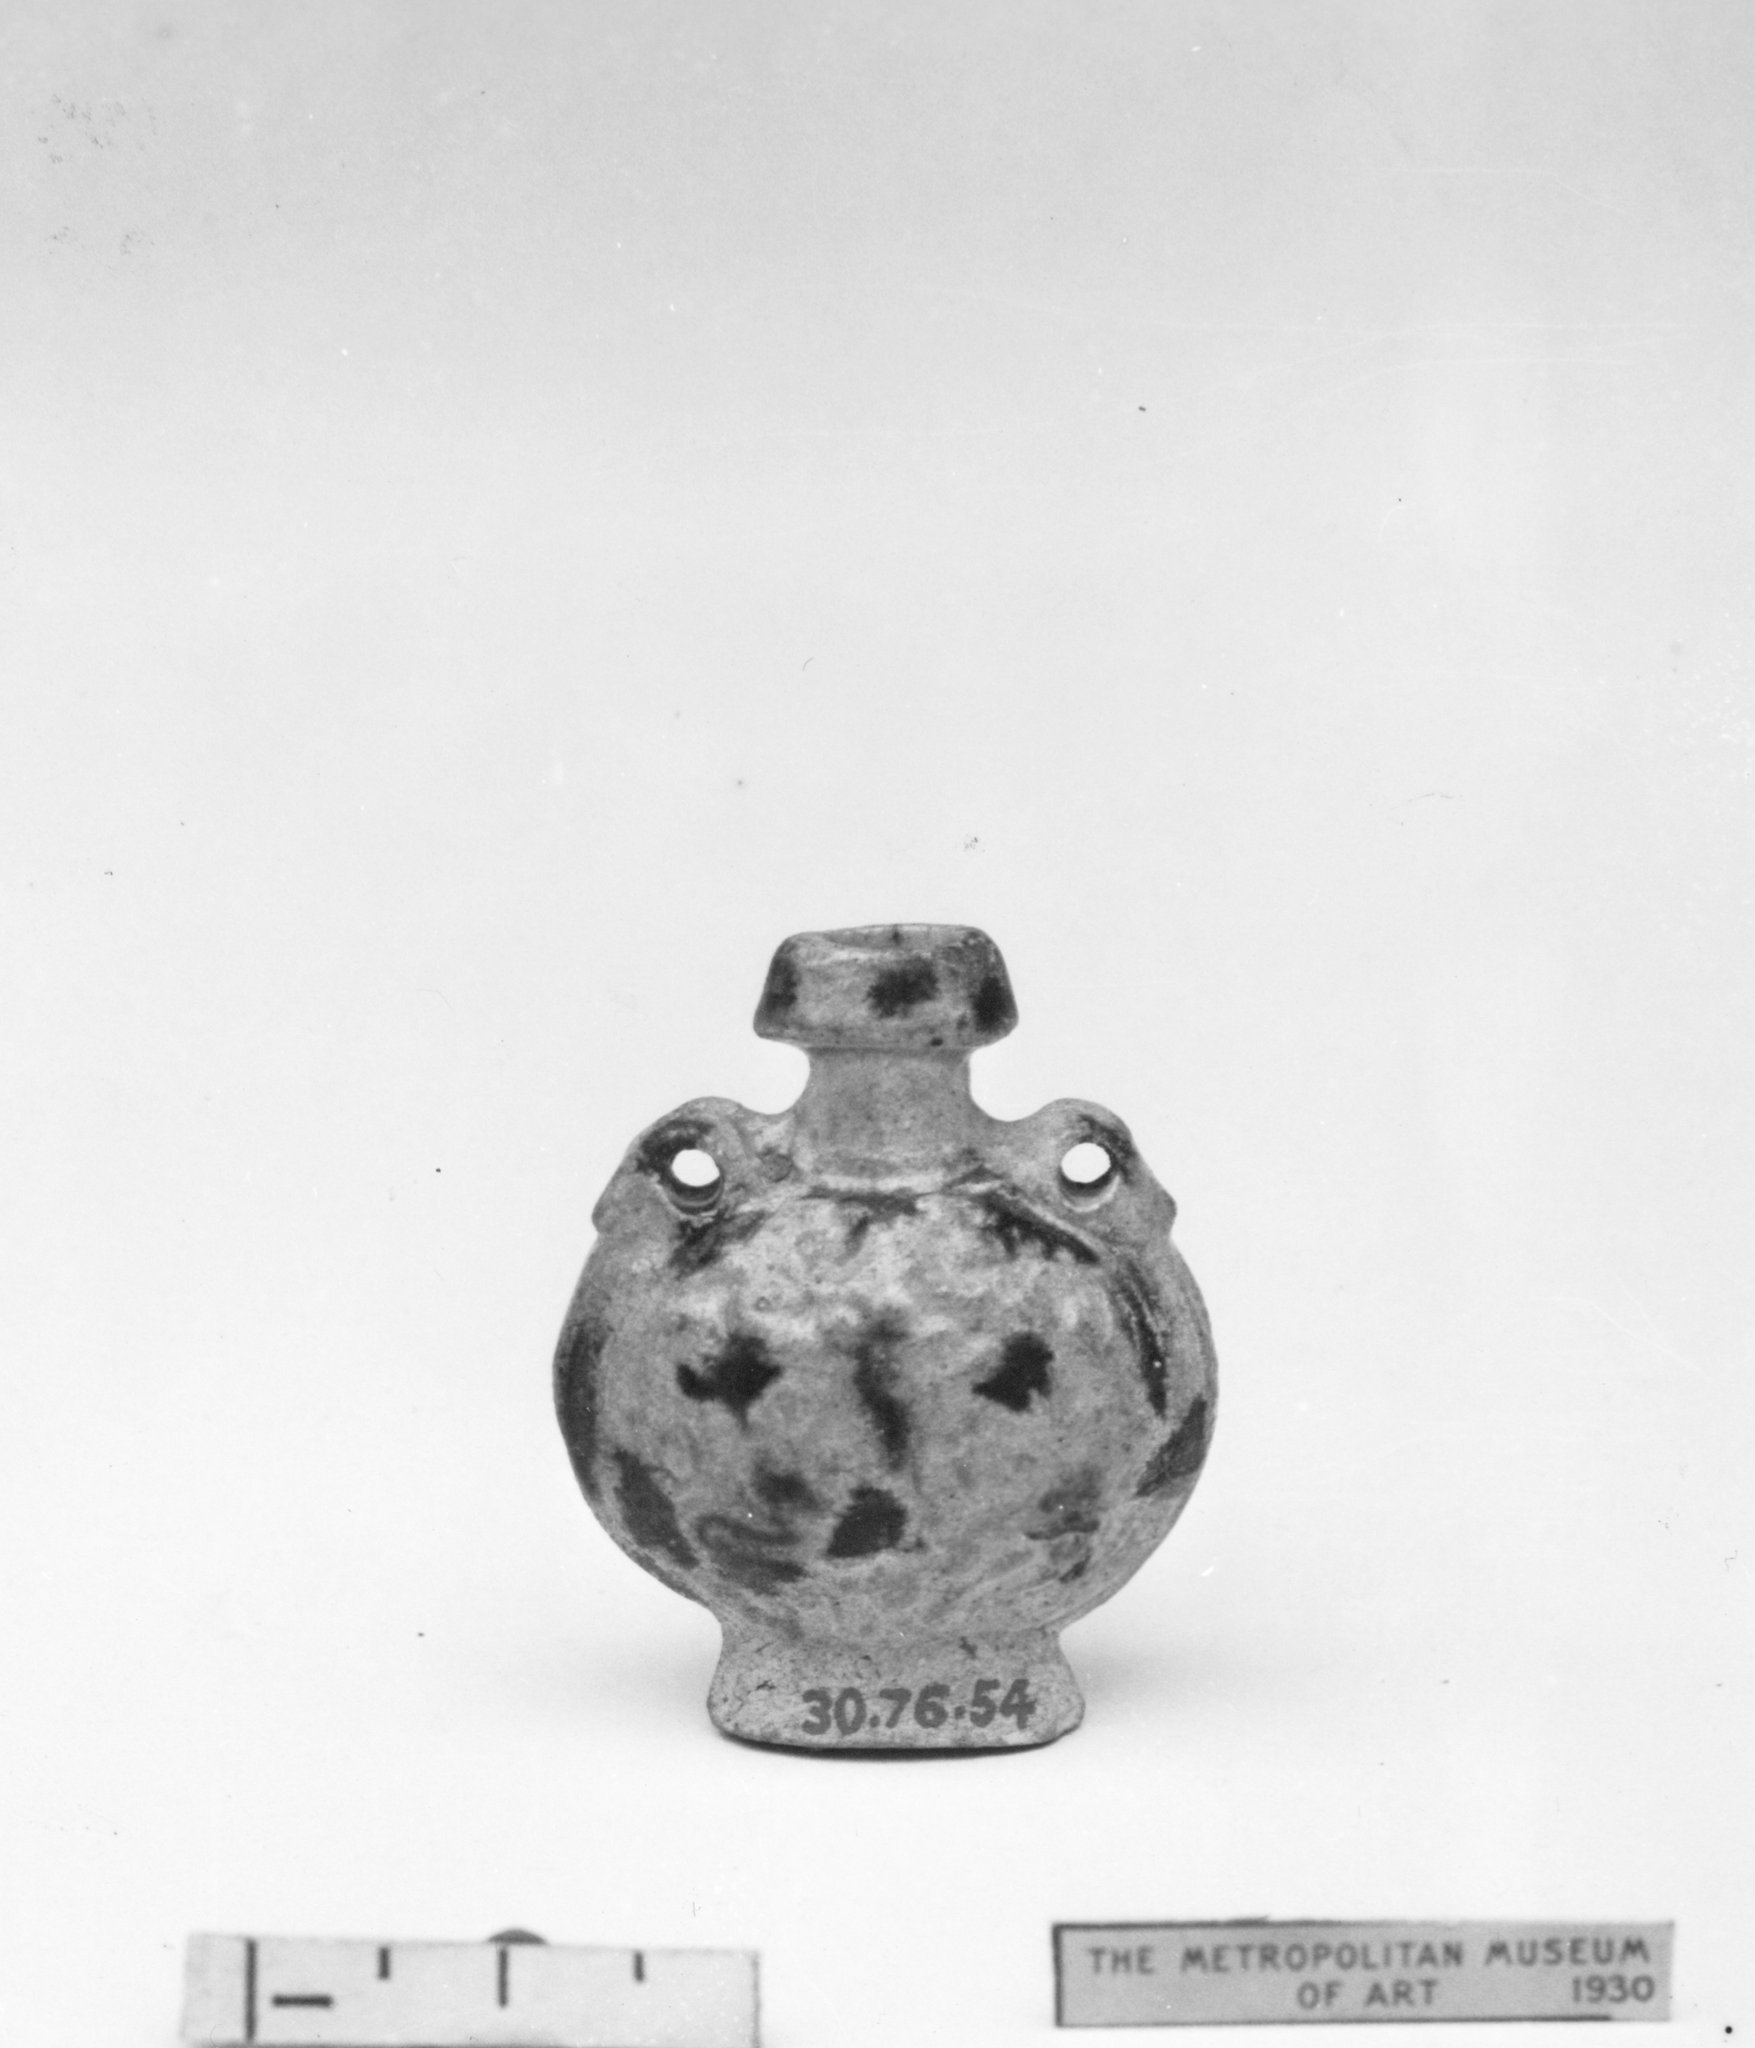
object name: pilgrim bottle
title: Miniature pilgrim bottle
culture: chinese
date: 601-800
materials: earthenware, glaze